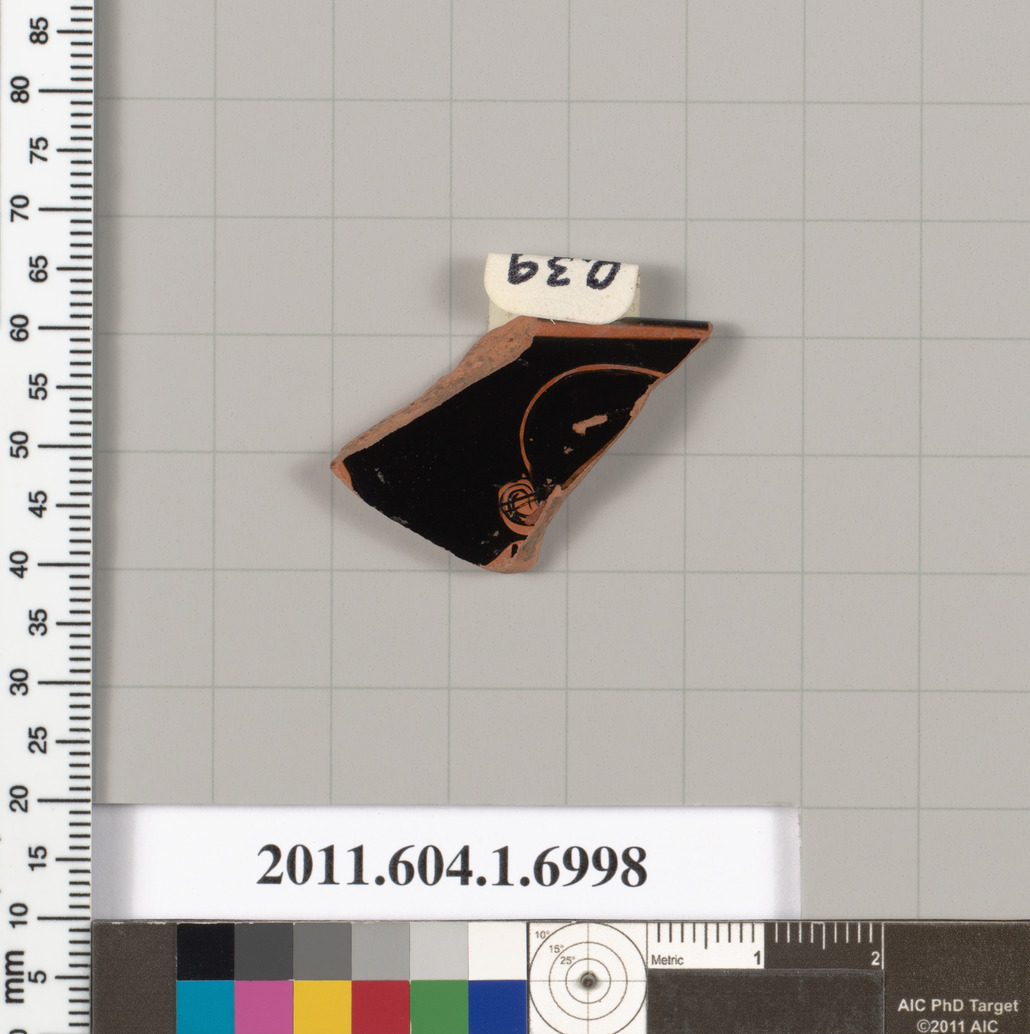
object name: kylix fragment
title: Terracotta rim fragment of a kylix (drinking cup)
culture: greek, attic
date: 500-480 BCE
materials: terracotta